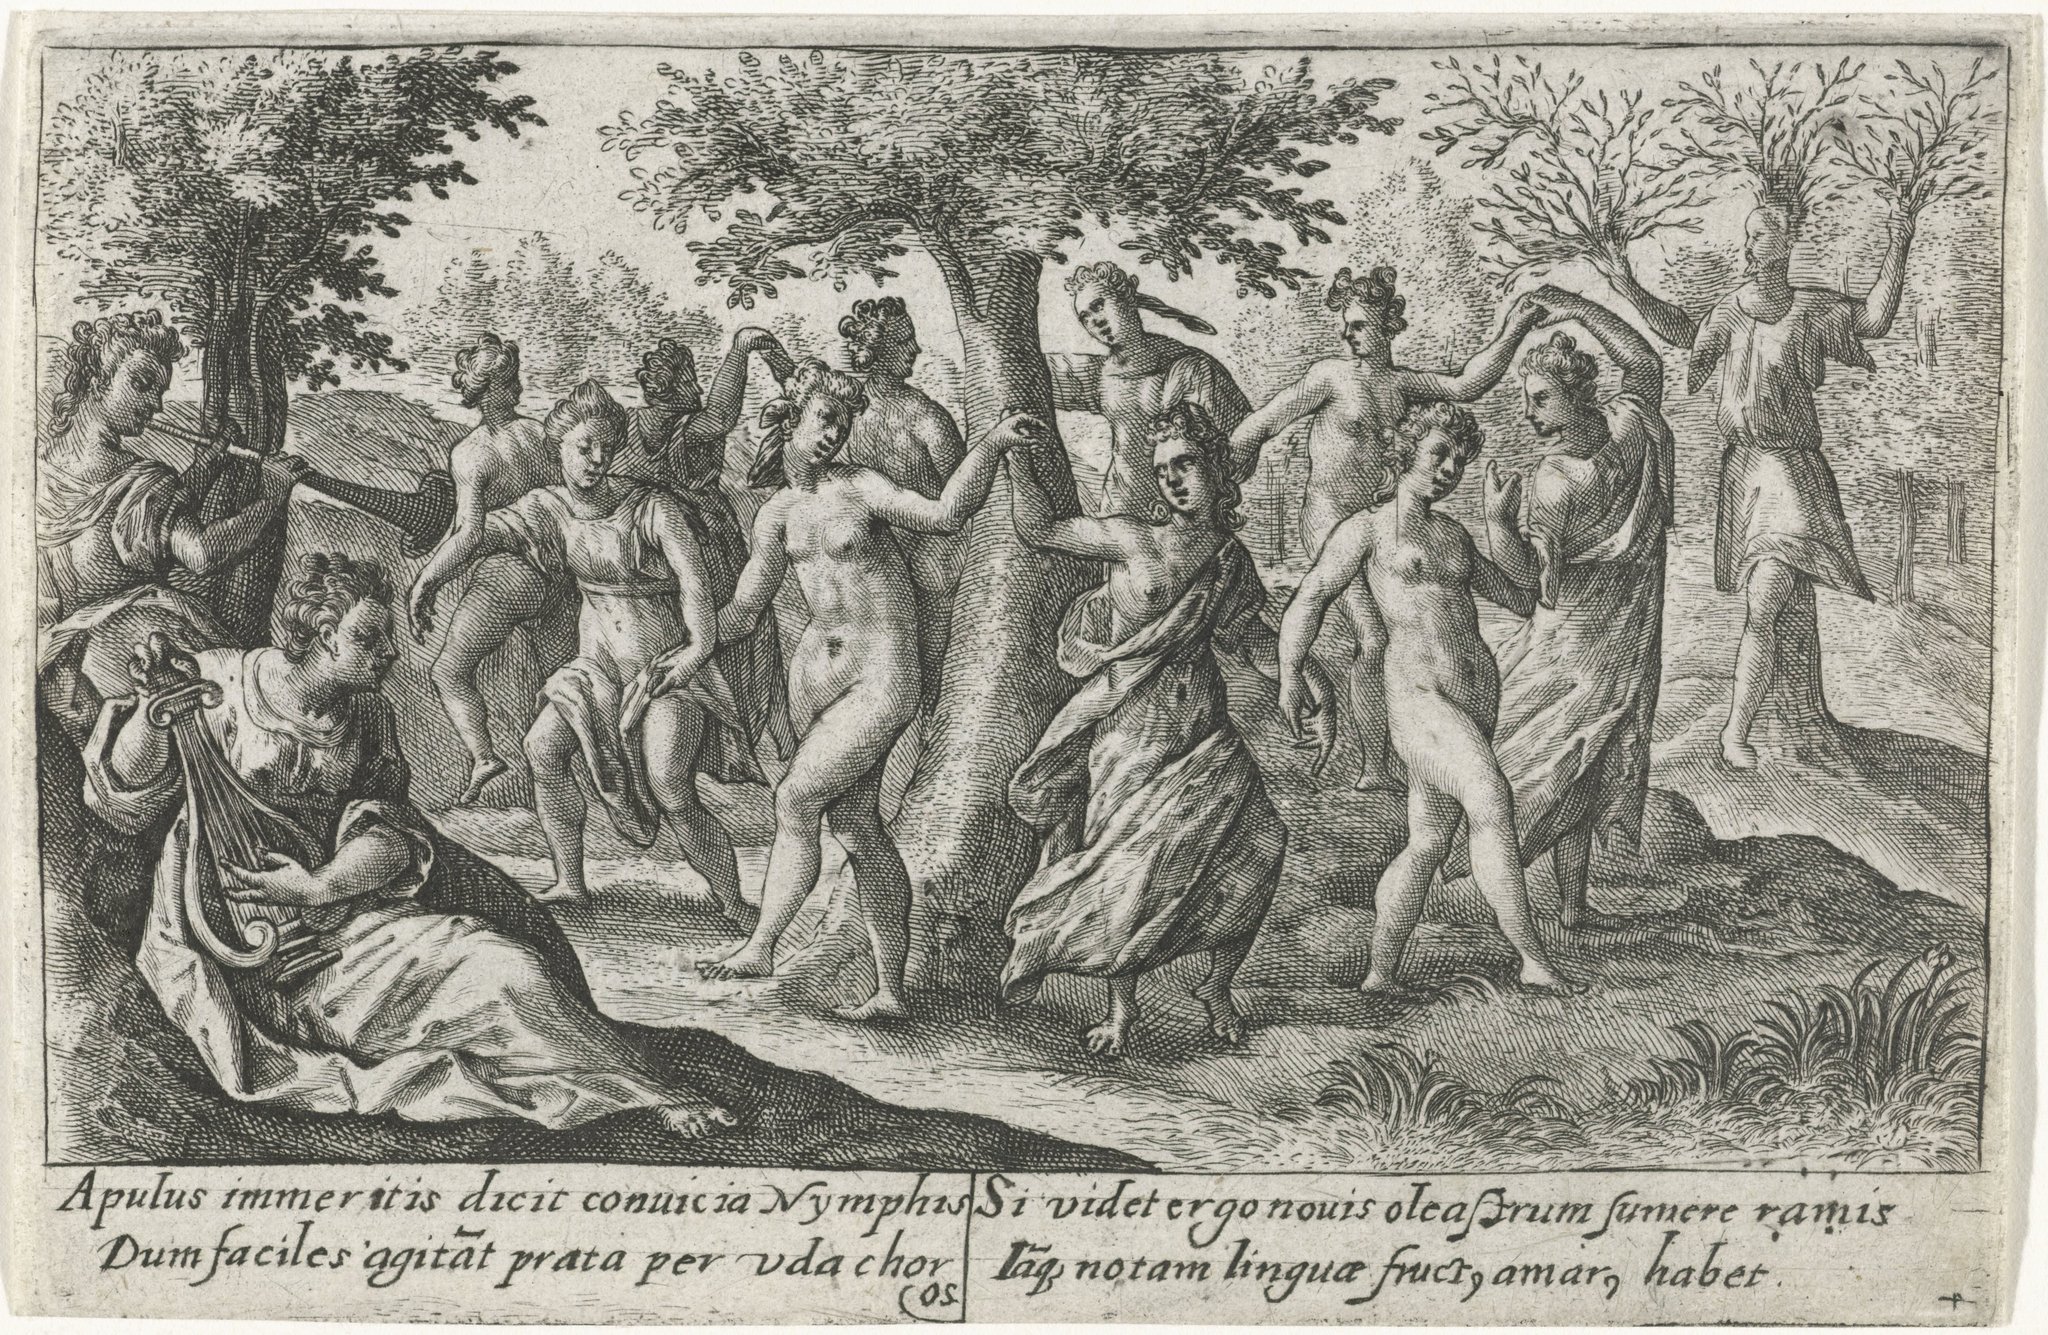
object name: print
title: Apulische herder in een olijfboom veranderd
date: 1602-1607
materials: paper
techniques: engraving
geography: cologne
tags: the apulian shepherd changed into an oleaster: the apulian shepherd is changed into an oleaster as punishment for mocking dancing nymphs (ovid, metamorphoses xiv 521)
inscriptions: collector's mark: Lugt 2228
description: Als straf voor het uitlachen van de dansende nimfen wordt de Apulische herder in een olijfboom veranderd. In de marge een vierregelig onderschrift, in twee kolommen, in het Latijn.